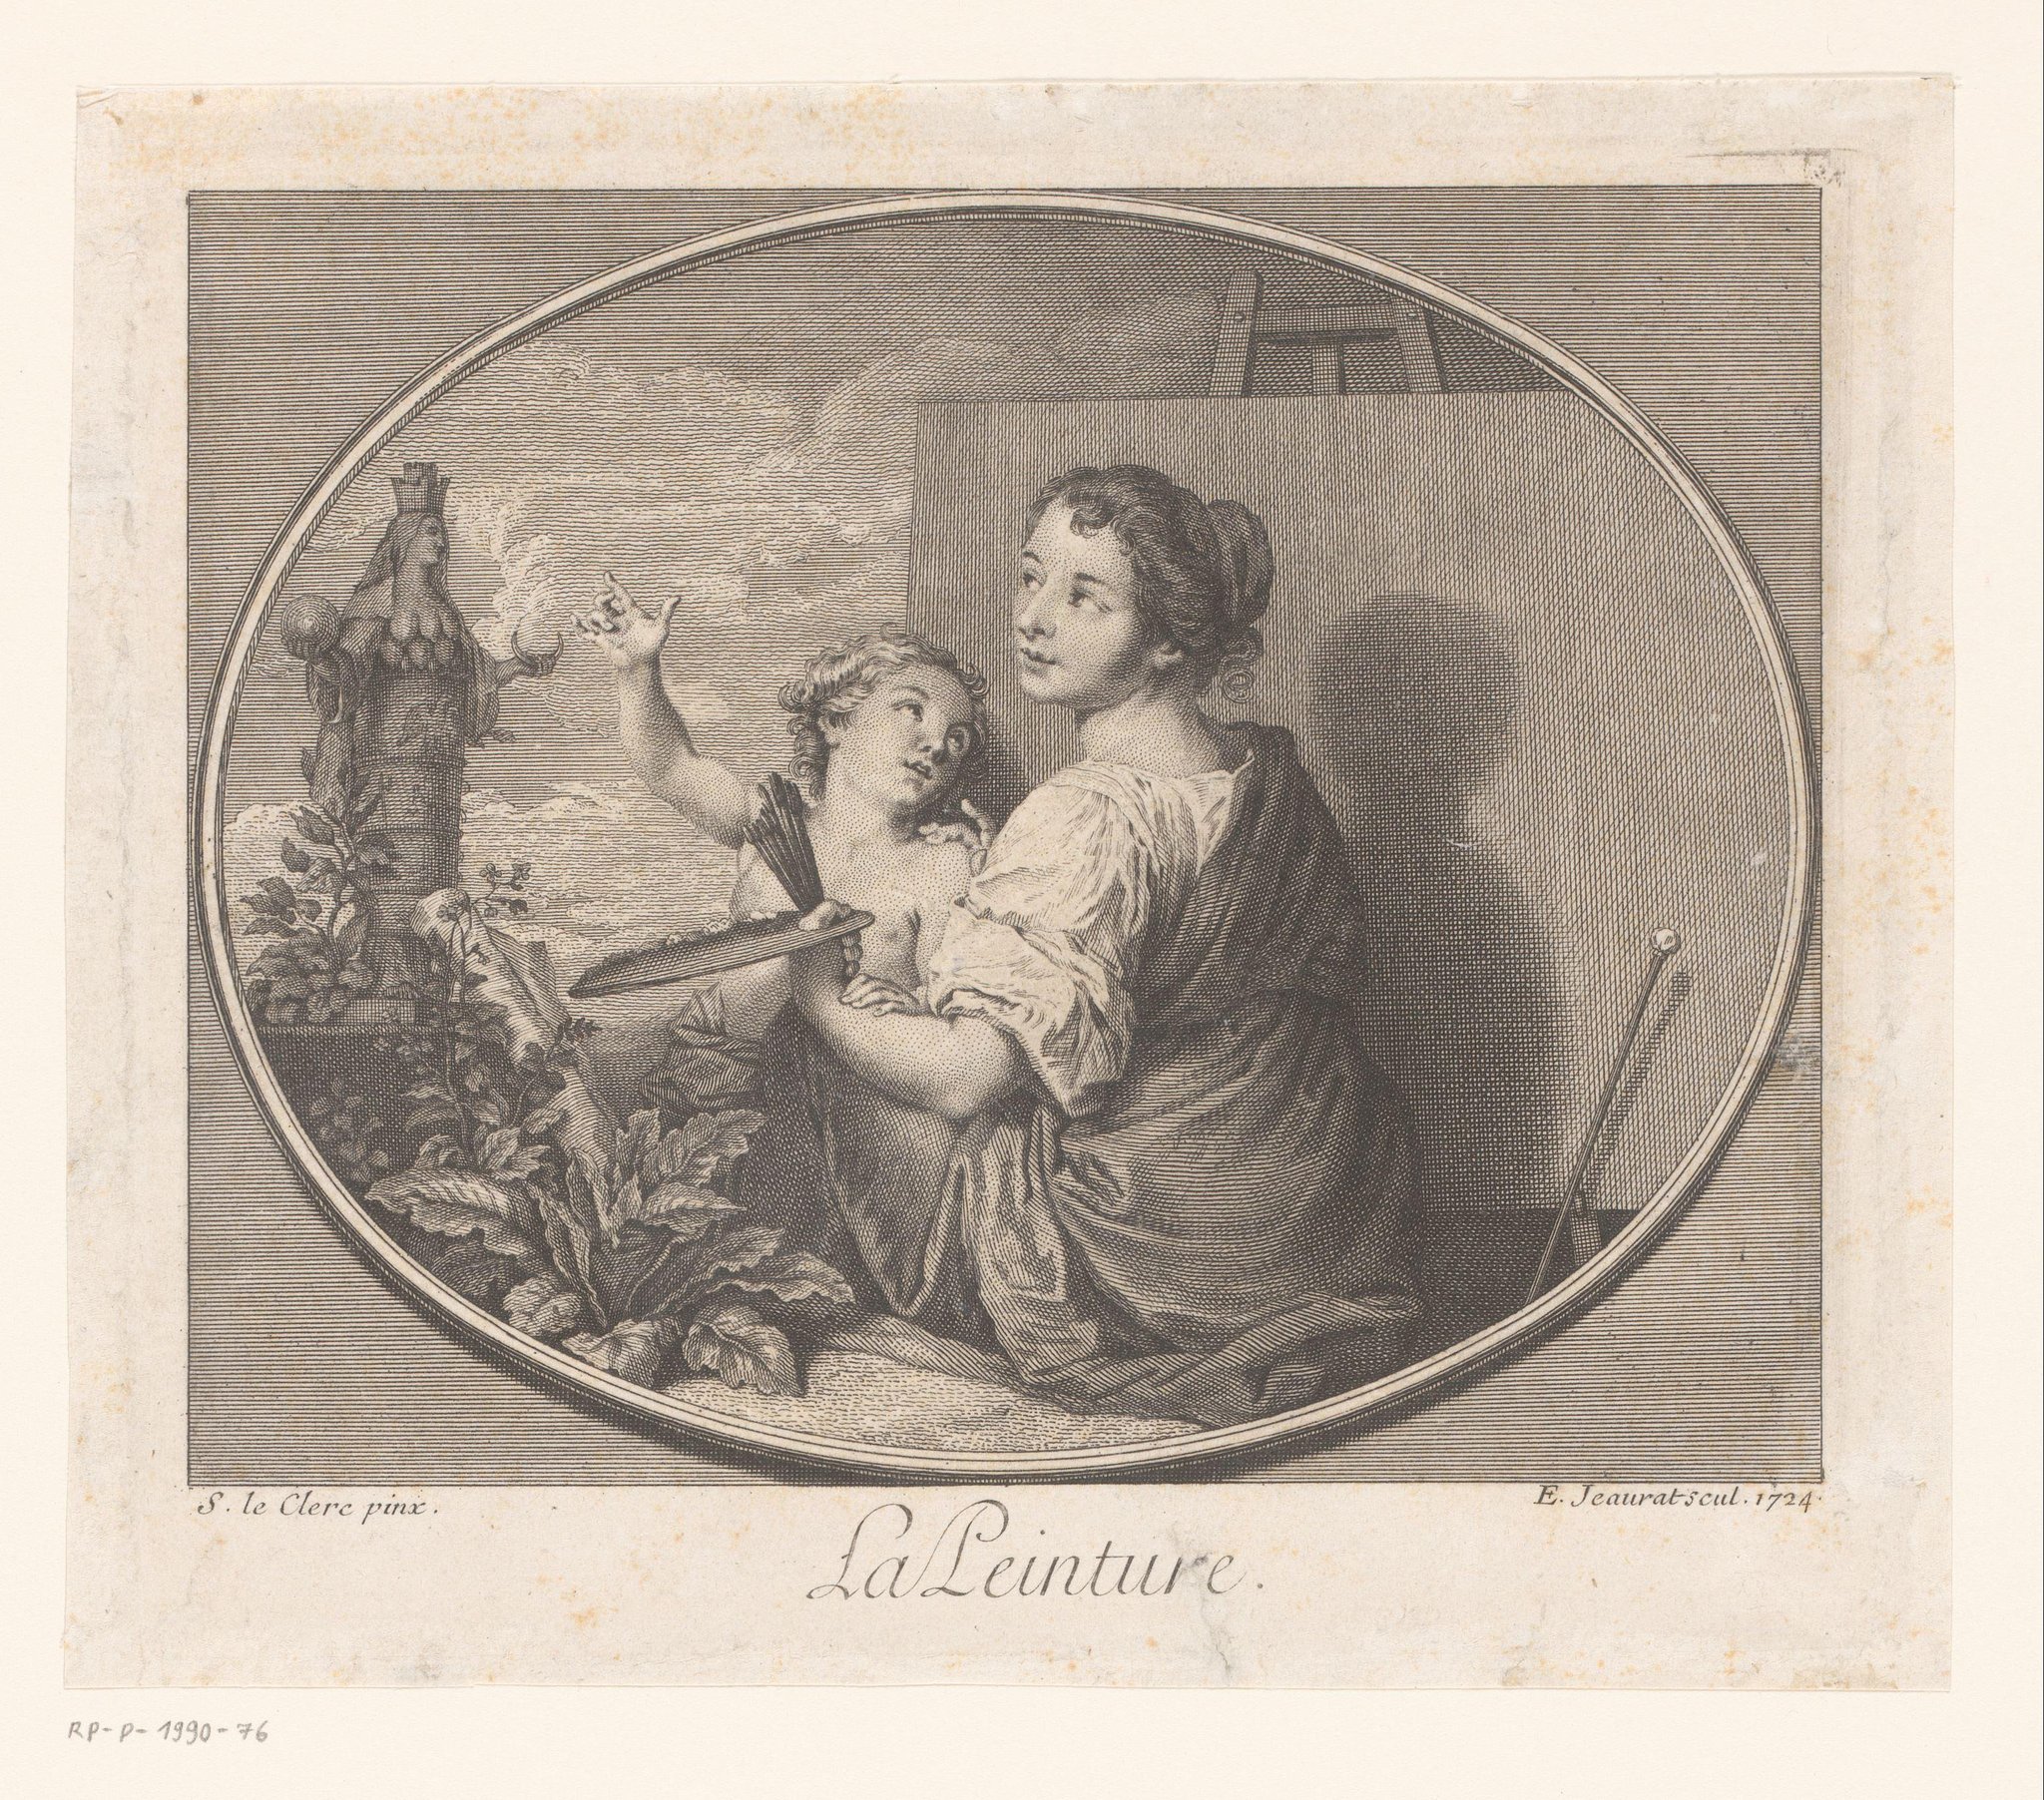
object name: print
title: Allegorie van de schilderkunst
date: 1724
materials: paper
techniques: engraving, etching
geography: france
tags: 'natura' (allegorical figure or scene; or as diana of ephesus, with many breasts); 'natura' (ripa), painting (including book-illumination, miniature-painting)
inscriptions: collector's mark: Lugt 2228